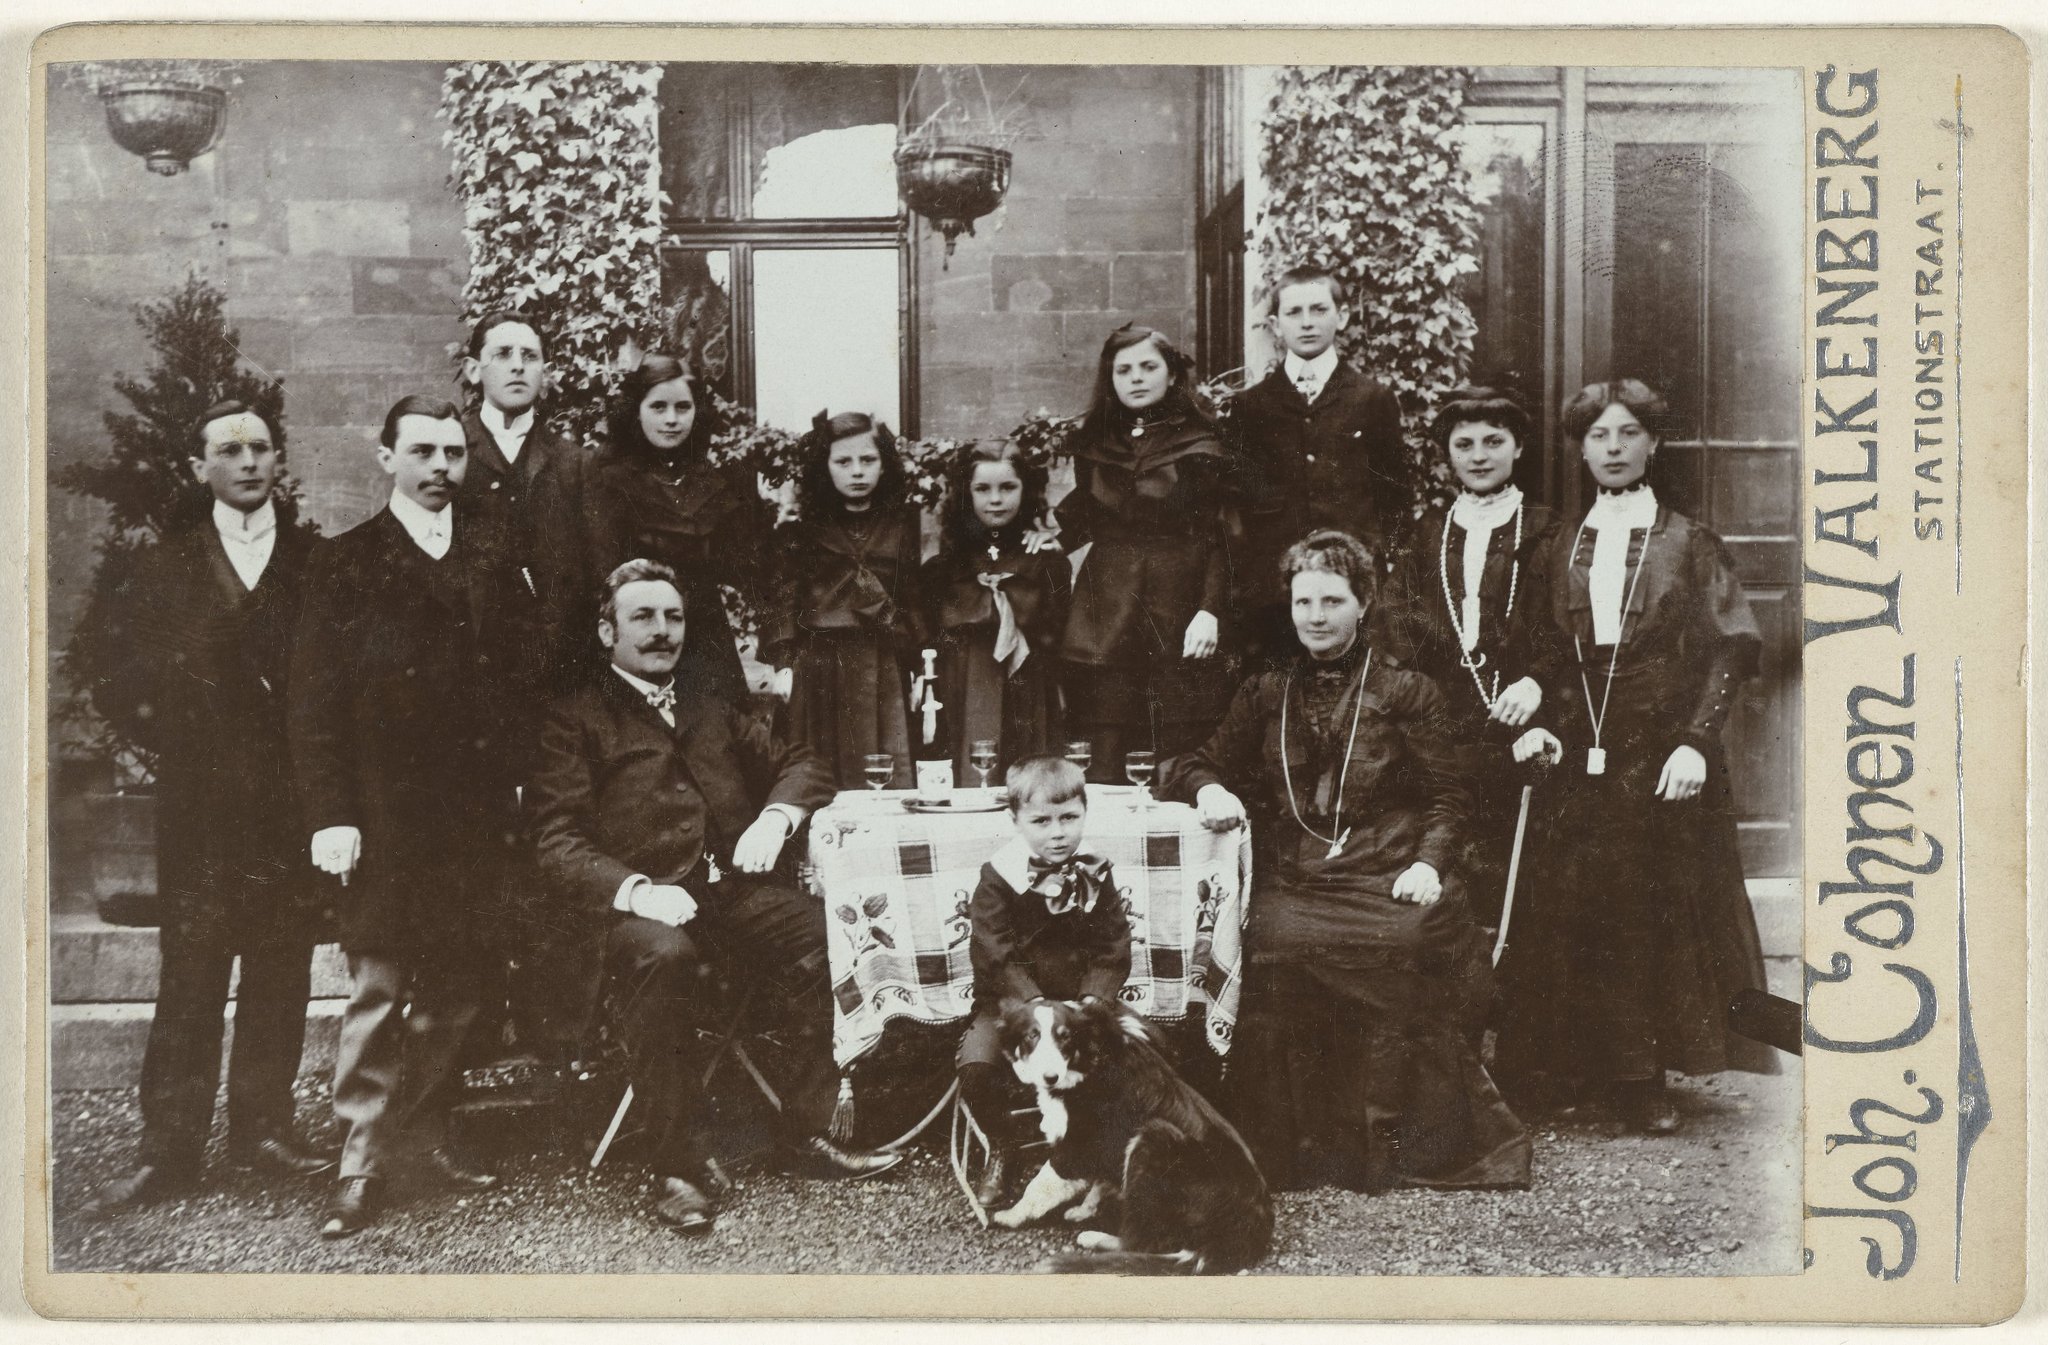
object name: photograph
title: Familieportret van de familie Vecqueray in Valkenburg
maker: johan joachim cohnen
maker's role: publisher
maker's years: 1885-1947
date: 1906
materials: cardboard, paper, photographic support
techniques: albumen print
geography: valkenburg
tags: valkenburg (limburg)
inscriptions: annotation: ‘Der hochgeehrten Familie Kessler de Lange, zur freundlichen Erinnerung an Ihren Sommer-Aufenthalt im Kurhaus-Valkenburg. Die dankbare Familie Vecqueray.’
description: Familie portret van de familie Vecqueray in Valkenburg, verzonden als bedankje aan de familie Kessler de Lange. Aan de rechterkant staan alle vrouwen en aan de linkerkant de mannen. Voor in het midden zit de jongste zoon met de hond voor de tafel.